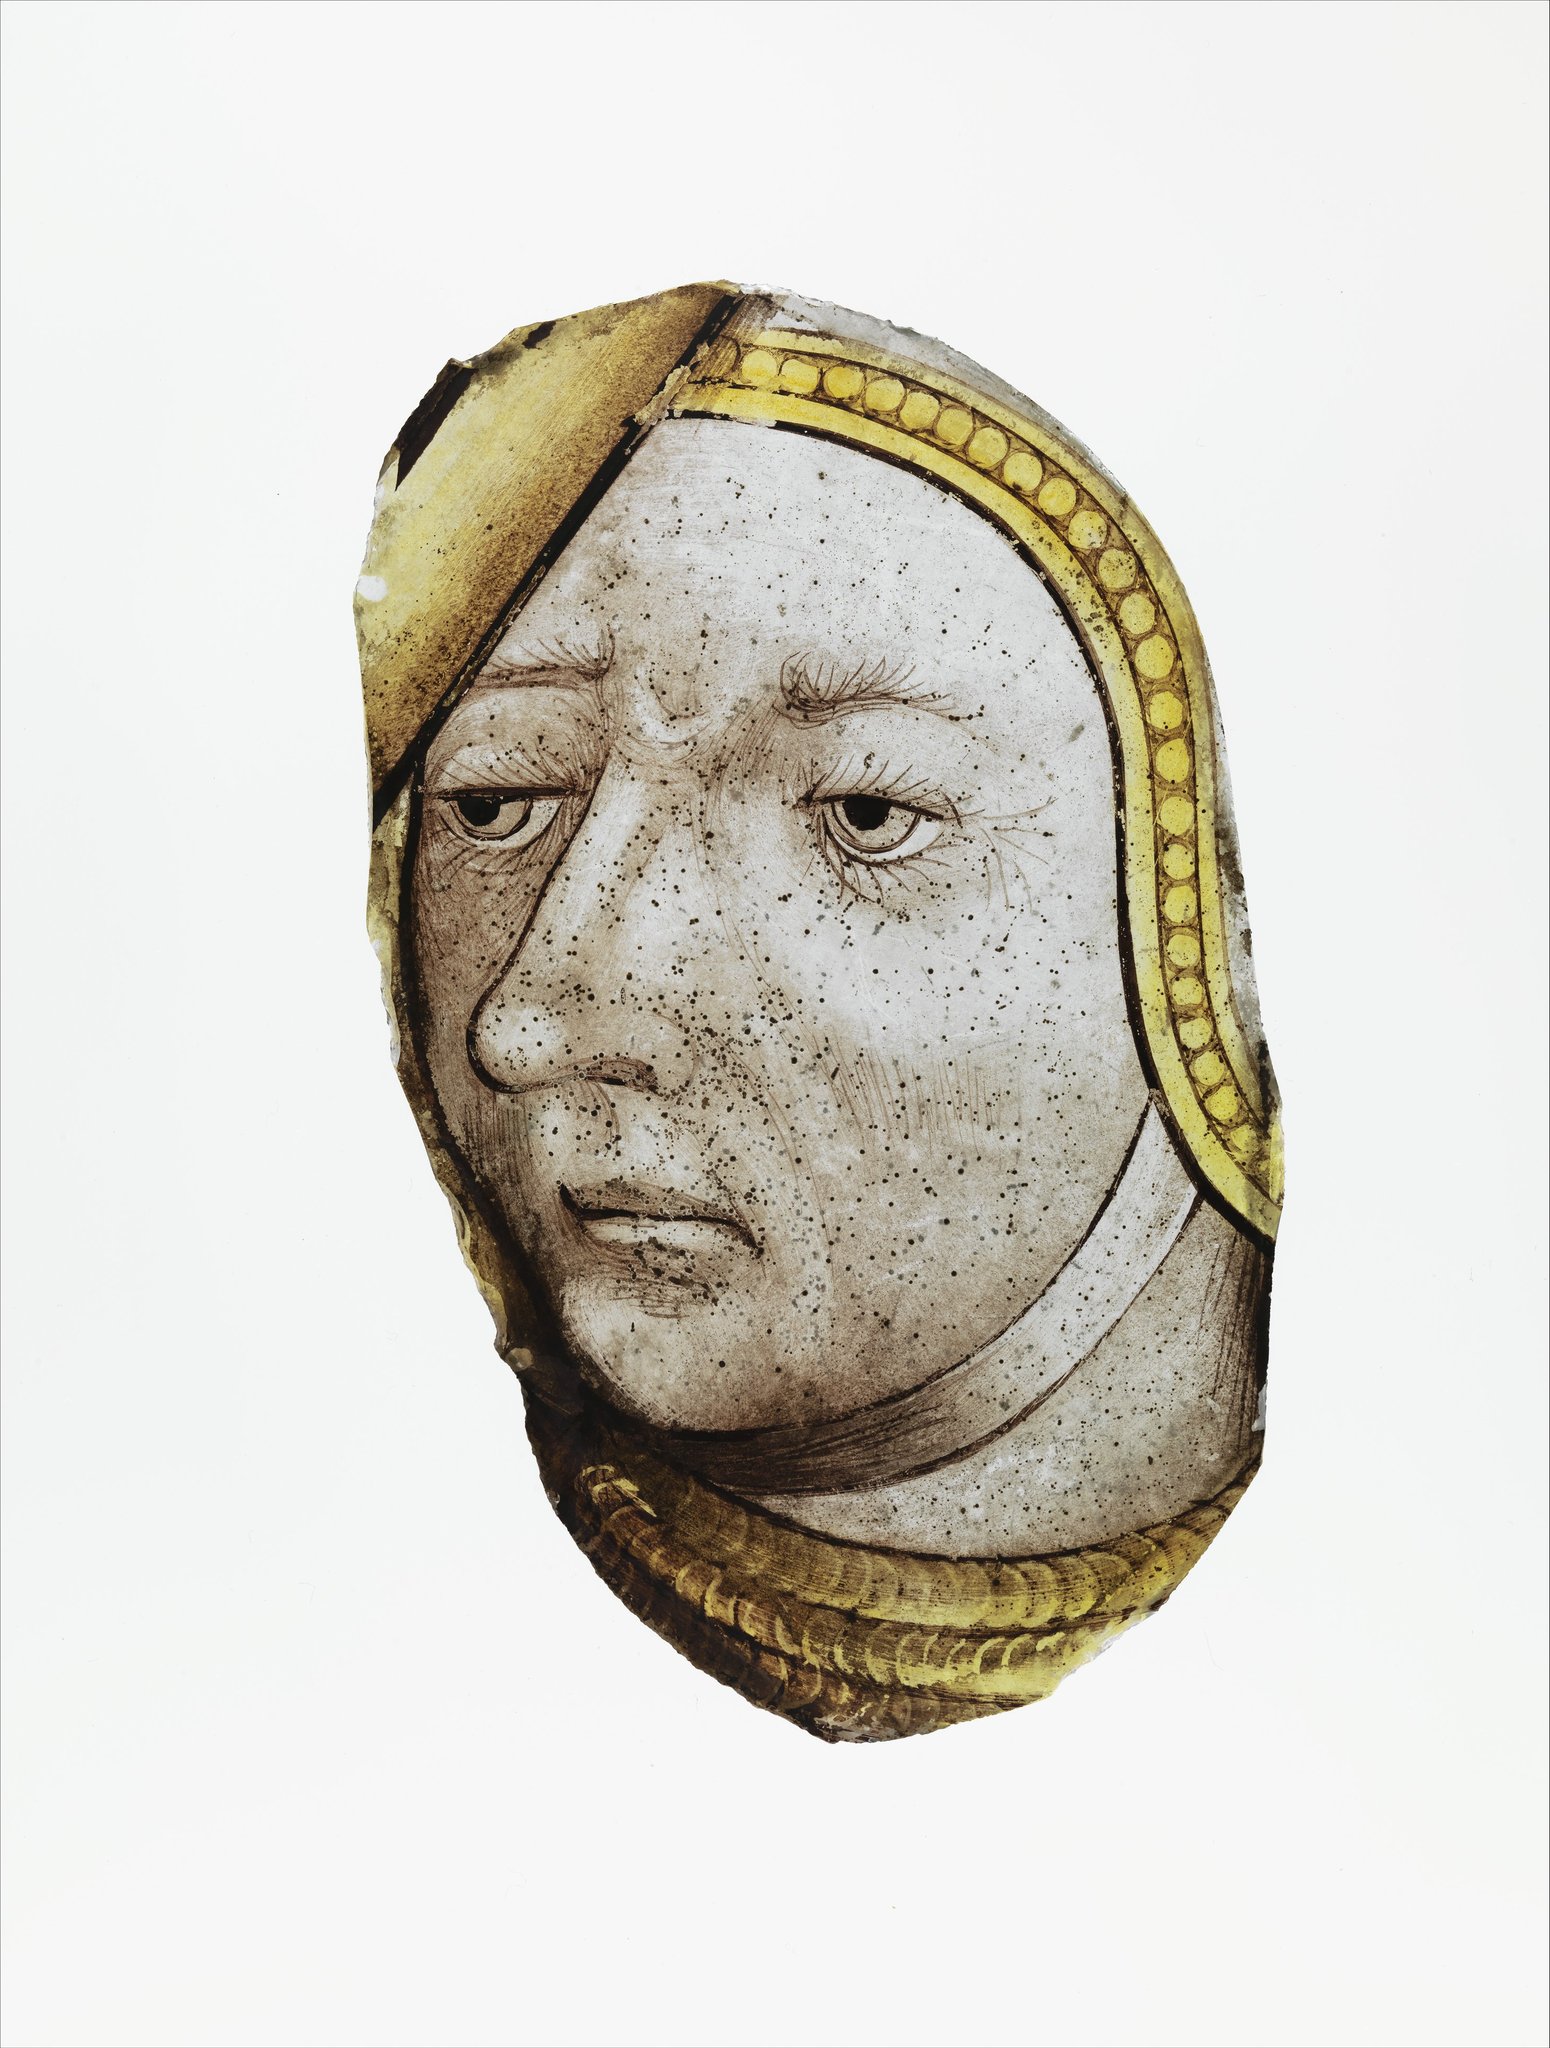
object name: stained glass fragment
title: Head of a Woman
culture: french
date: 1440-1460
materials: glass, paint, pigment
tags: heads,women